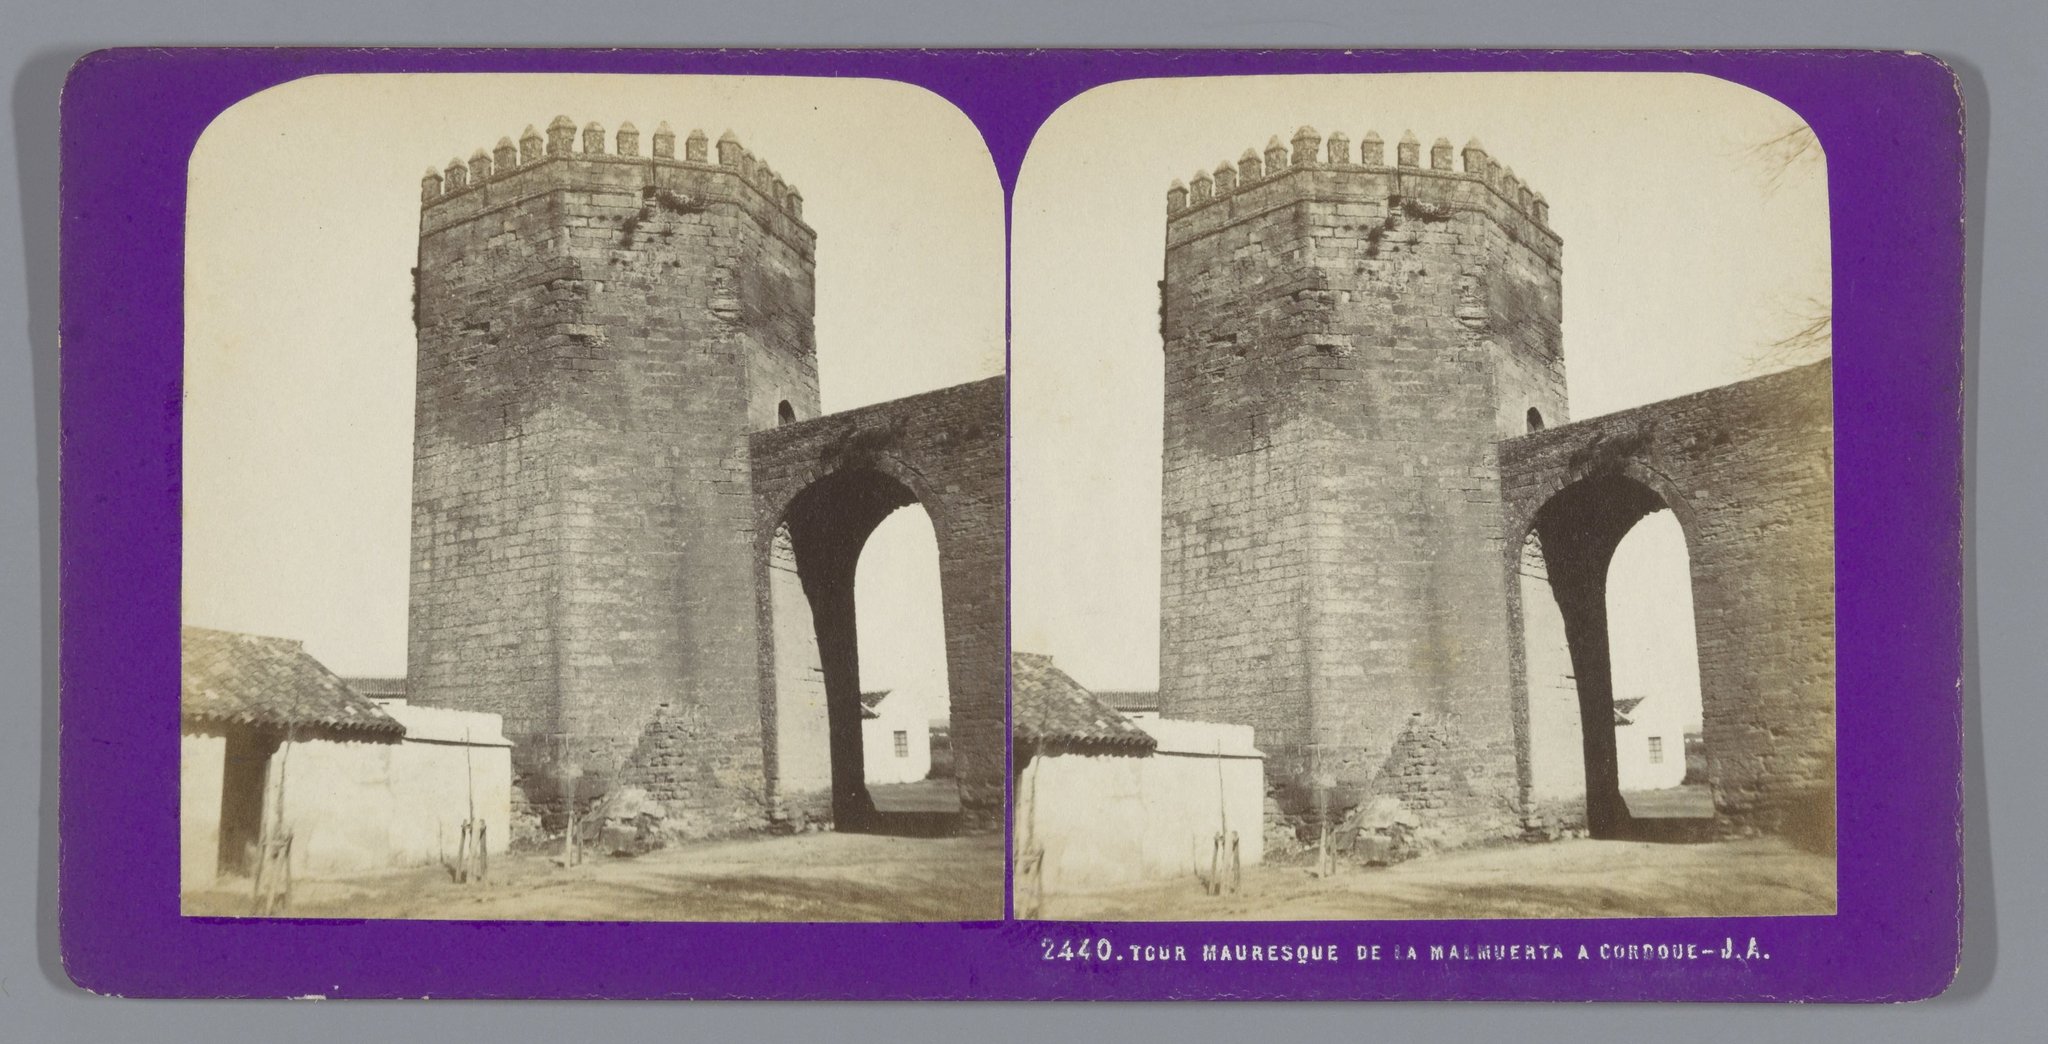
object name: stereograph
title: Tour Mauresque de la Malmuerta a Cordoue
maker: jean andrieu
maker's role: fotograaf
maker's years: 1816-1872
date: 1862-1876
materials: cardboard, photographic support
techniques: albumen print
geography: córdoba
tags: tower, clock tower ~ monumental adornment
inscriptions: number: ‘2440.’